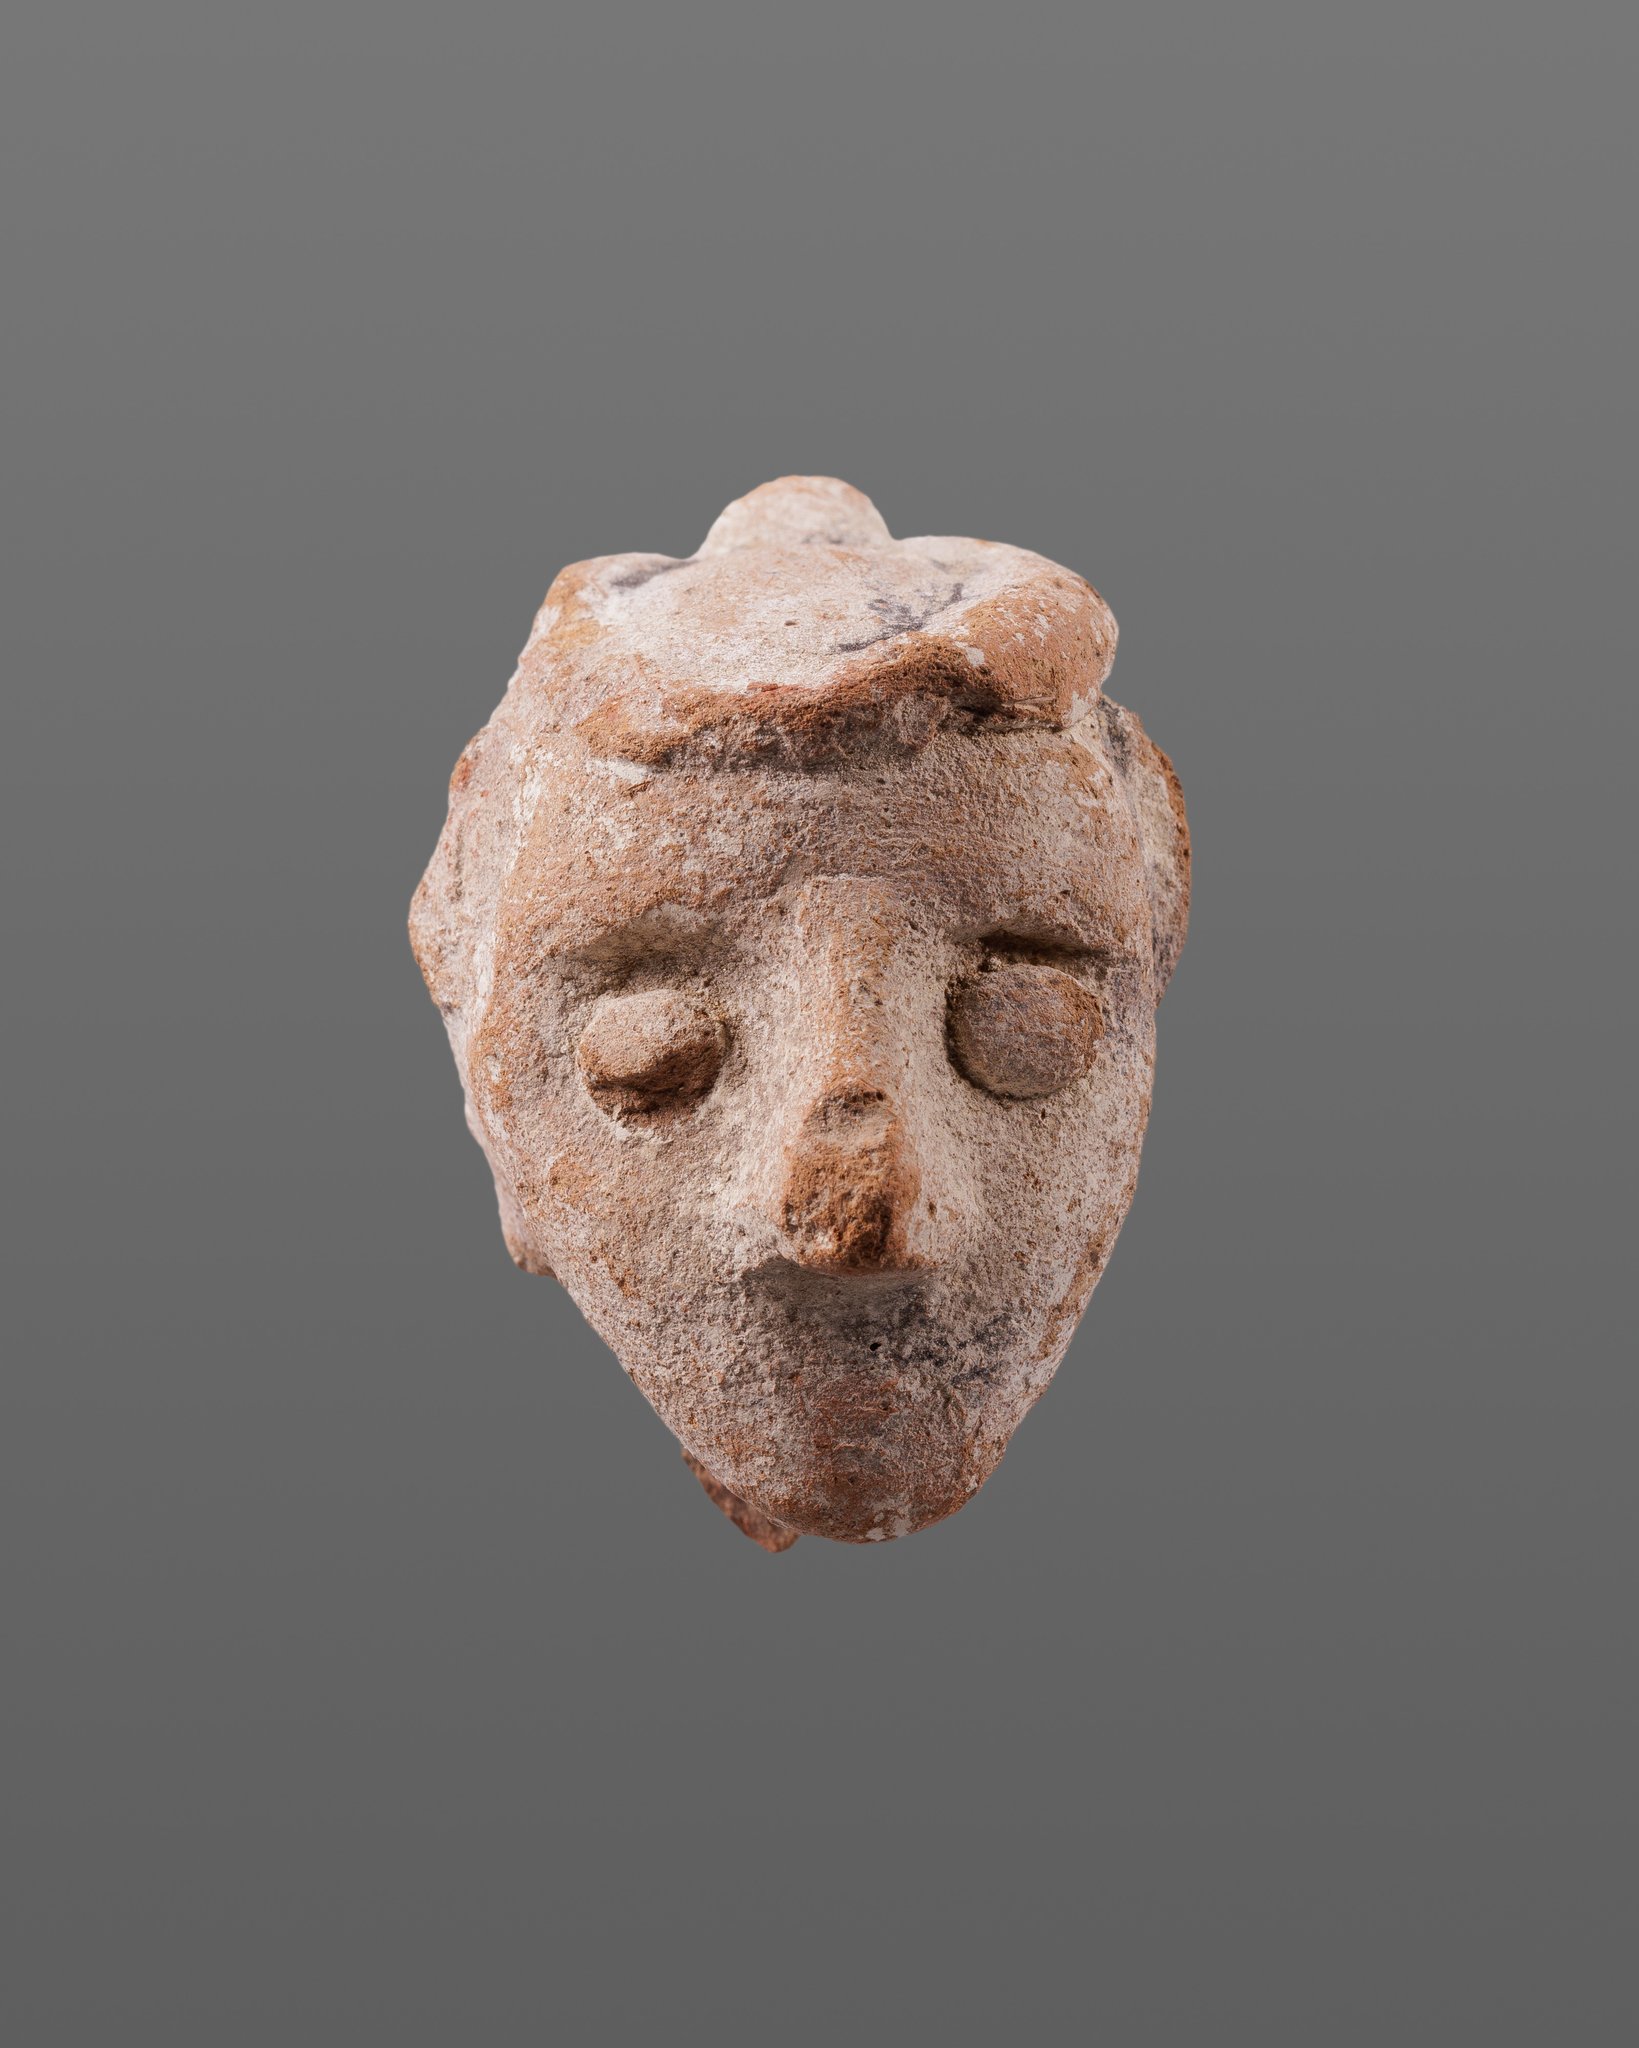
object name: figurine, head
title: Head from a human figure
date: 306-30 BCE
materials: paint, pottery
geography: egypt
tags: heads